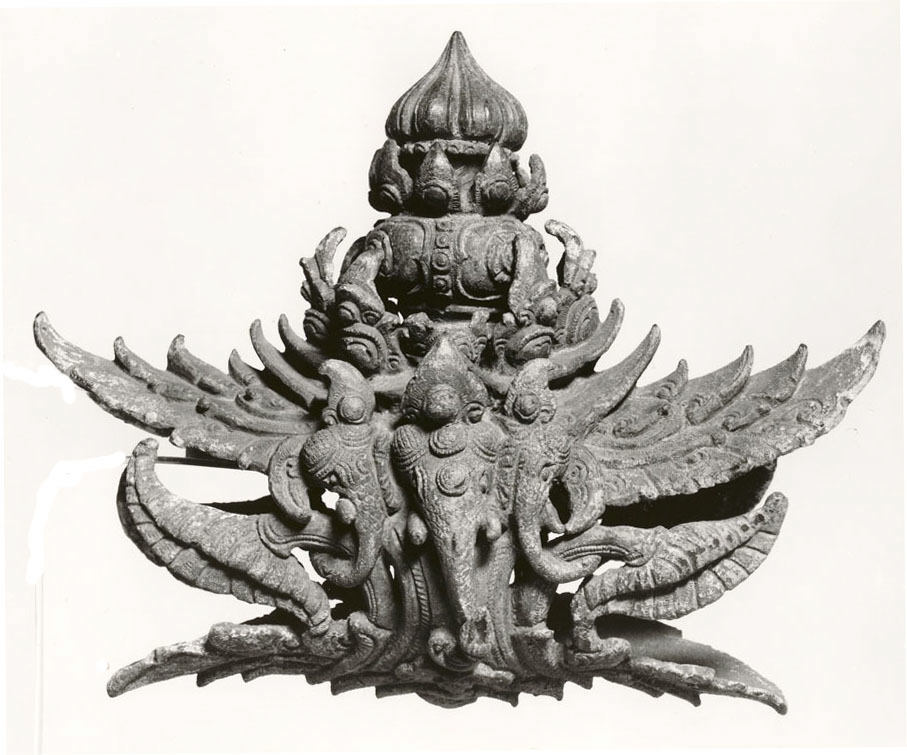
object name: fitting for a chariot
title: Fitting for a Chariot(?)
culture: cambodian or thai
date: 1151-1200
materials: bronze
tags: elephants